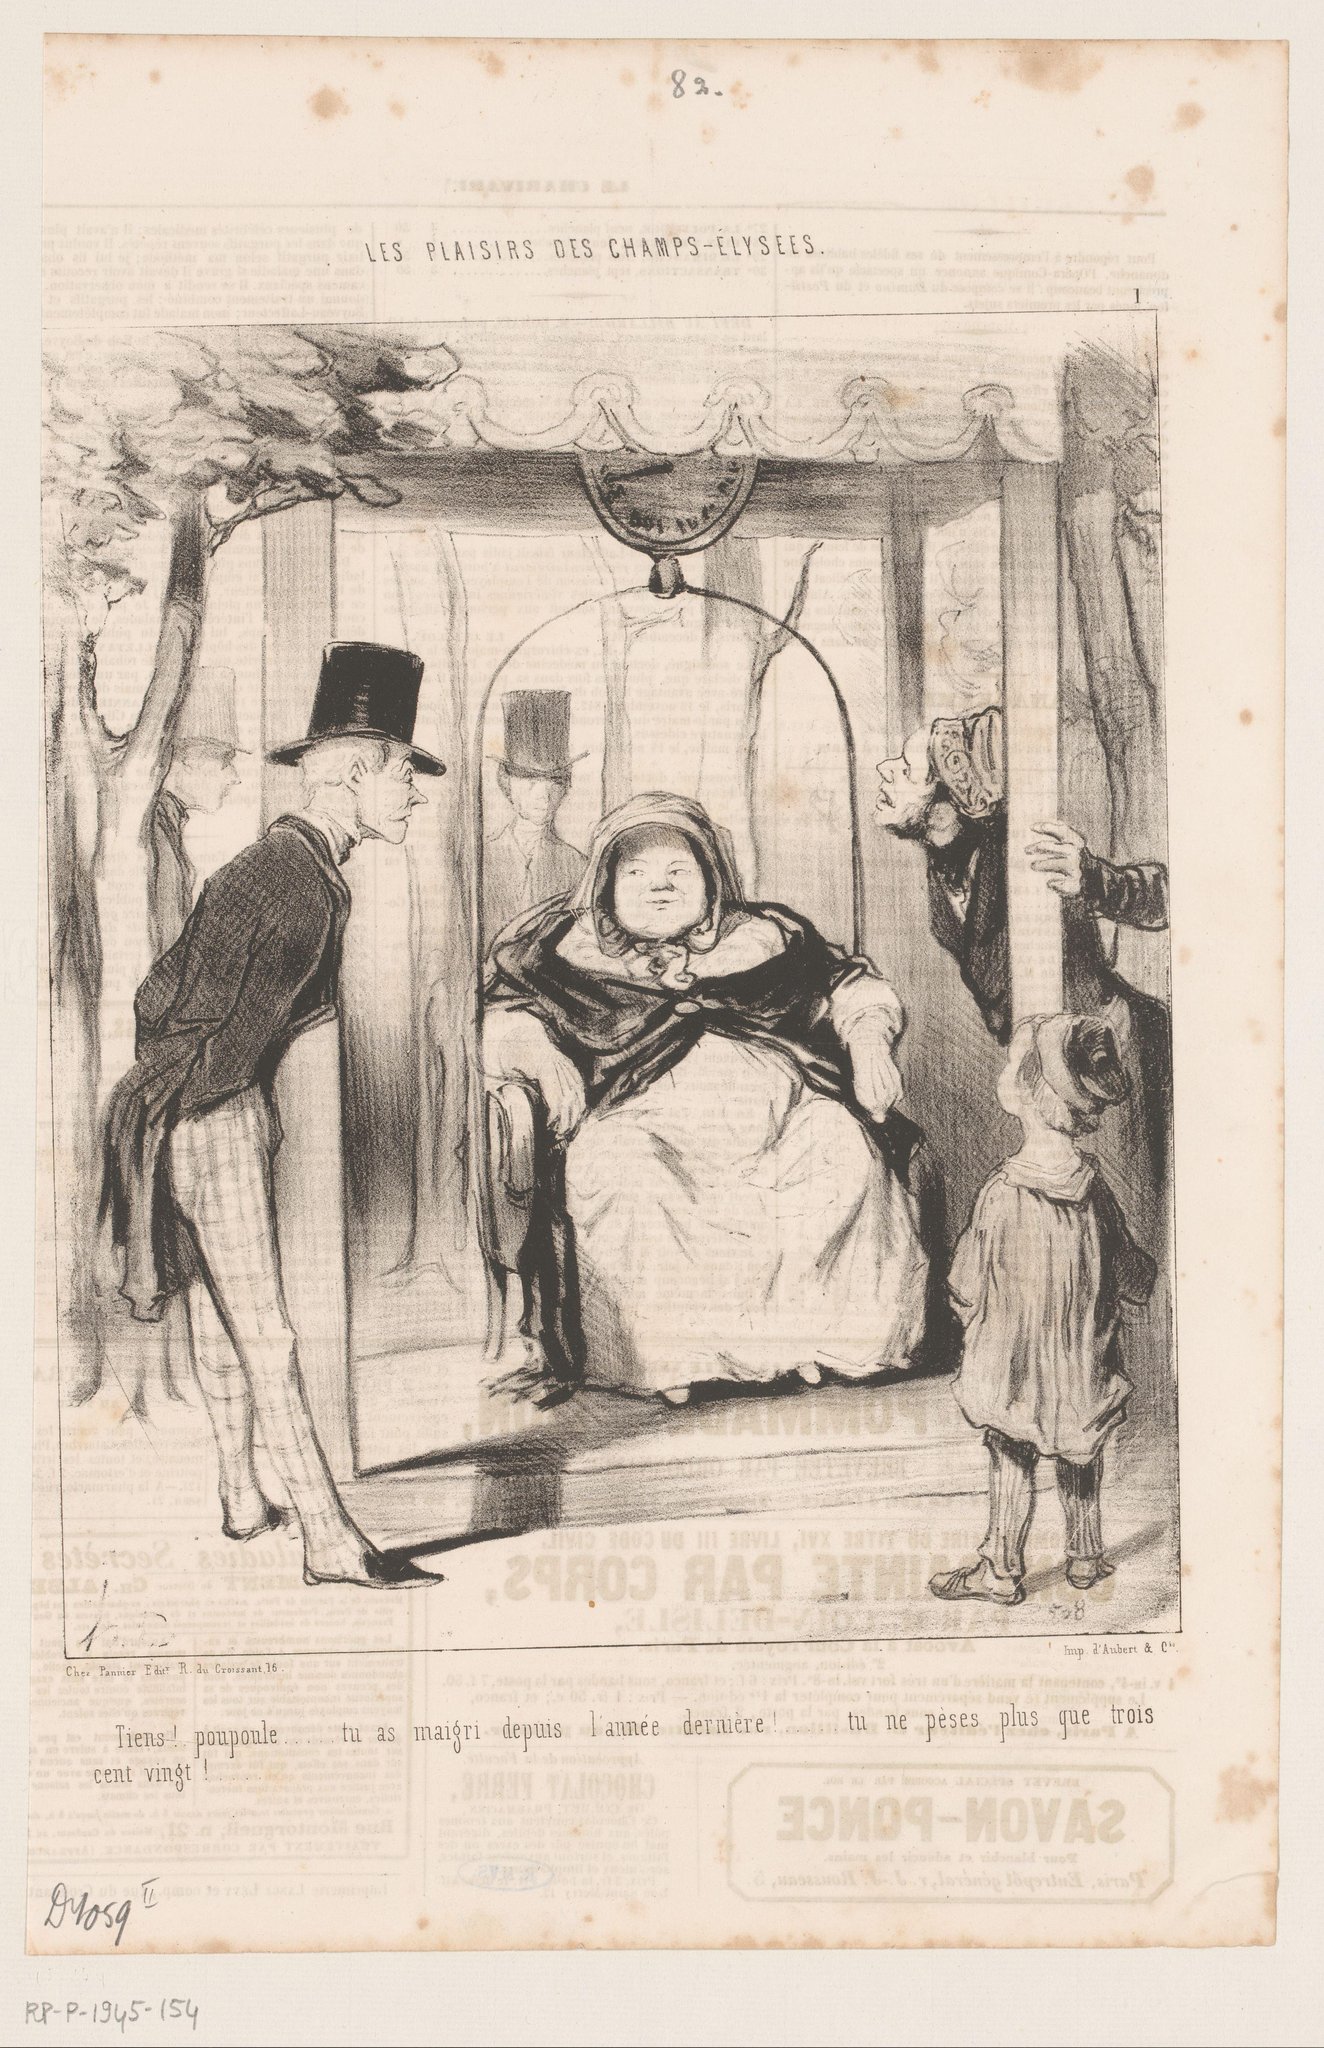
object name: cartoon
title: Scènes op de Champs-Élysées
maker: honoré daumier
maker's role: draughtsman, painter, print maker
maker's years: 1808-1879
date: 1843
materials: paper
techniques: lithograph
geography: paris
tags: fat (human type), caricatures (human types), scales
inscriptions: collector's mark: Lugt 2228a, number: ‘82’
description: Prent gepubliceerd in: Le Charivari, Aubert: Parijs, 20-08-1843. Le Charivari was een humoristische krant met karikaturen en (politieke) cartoons.